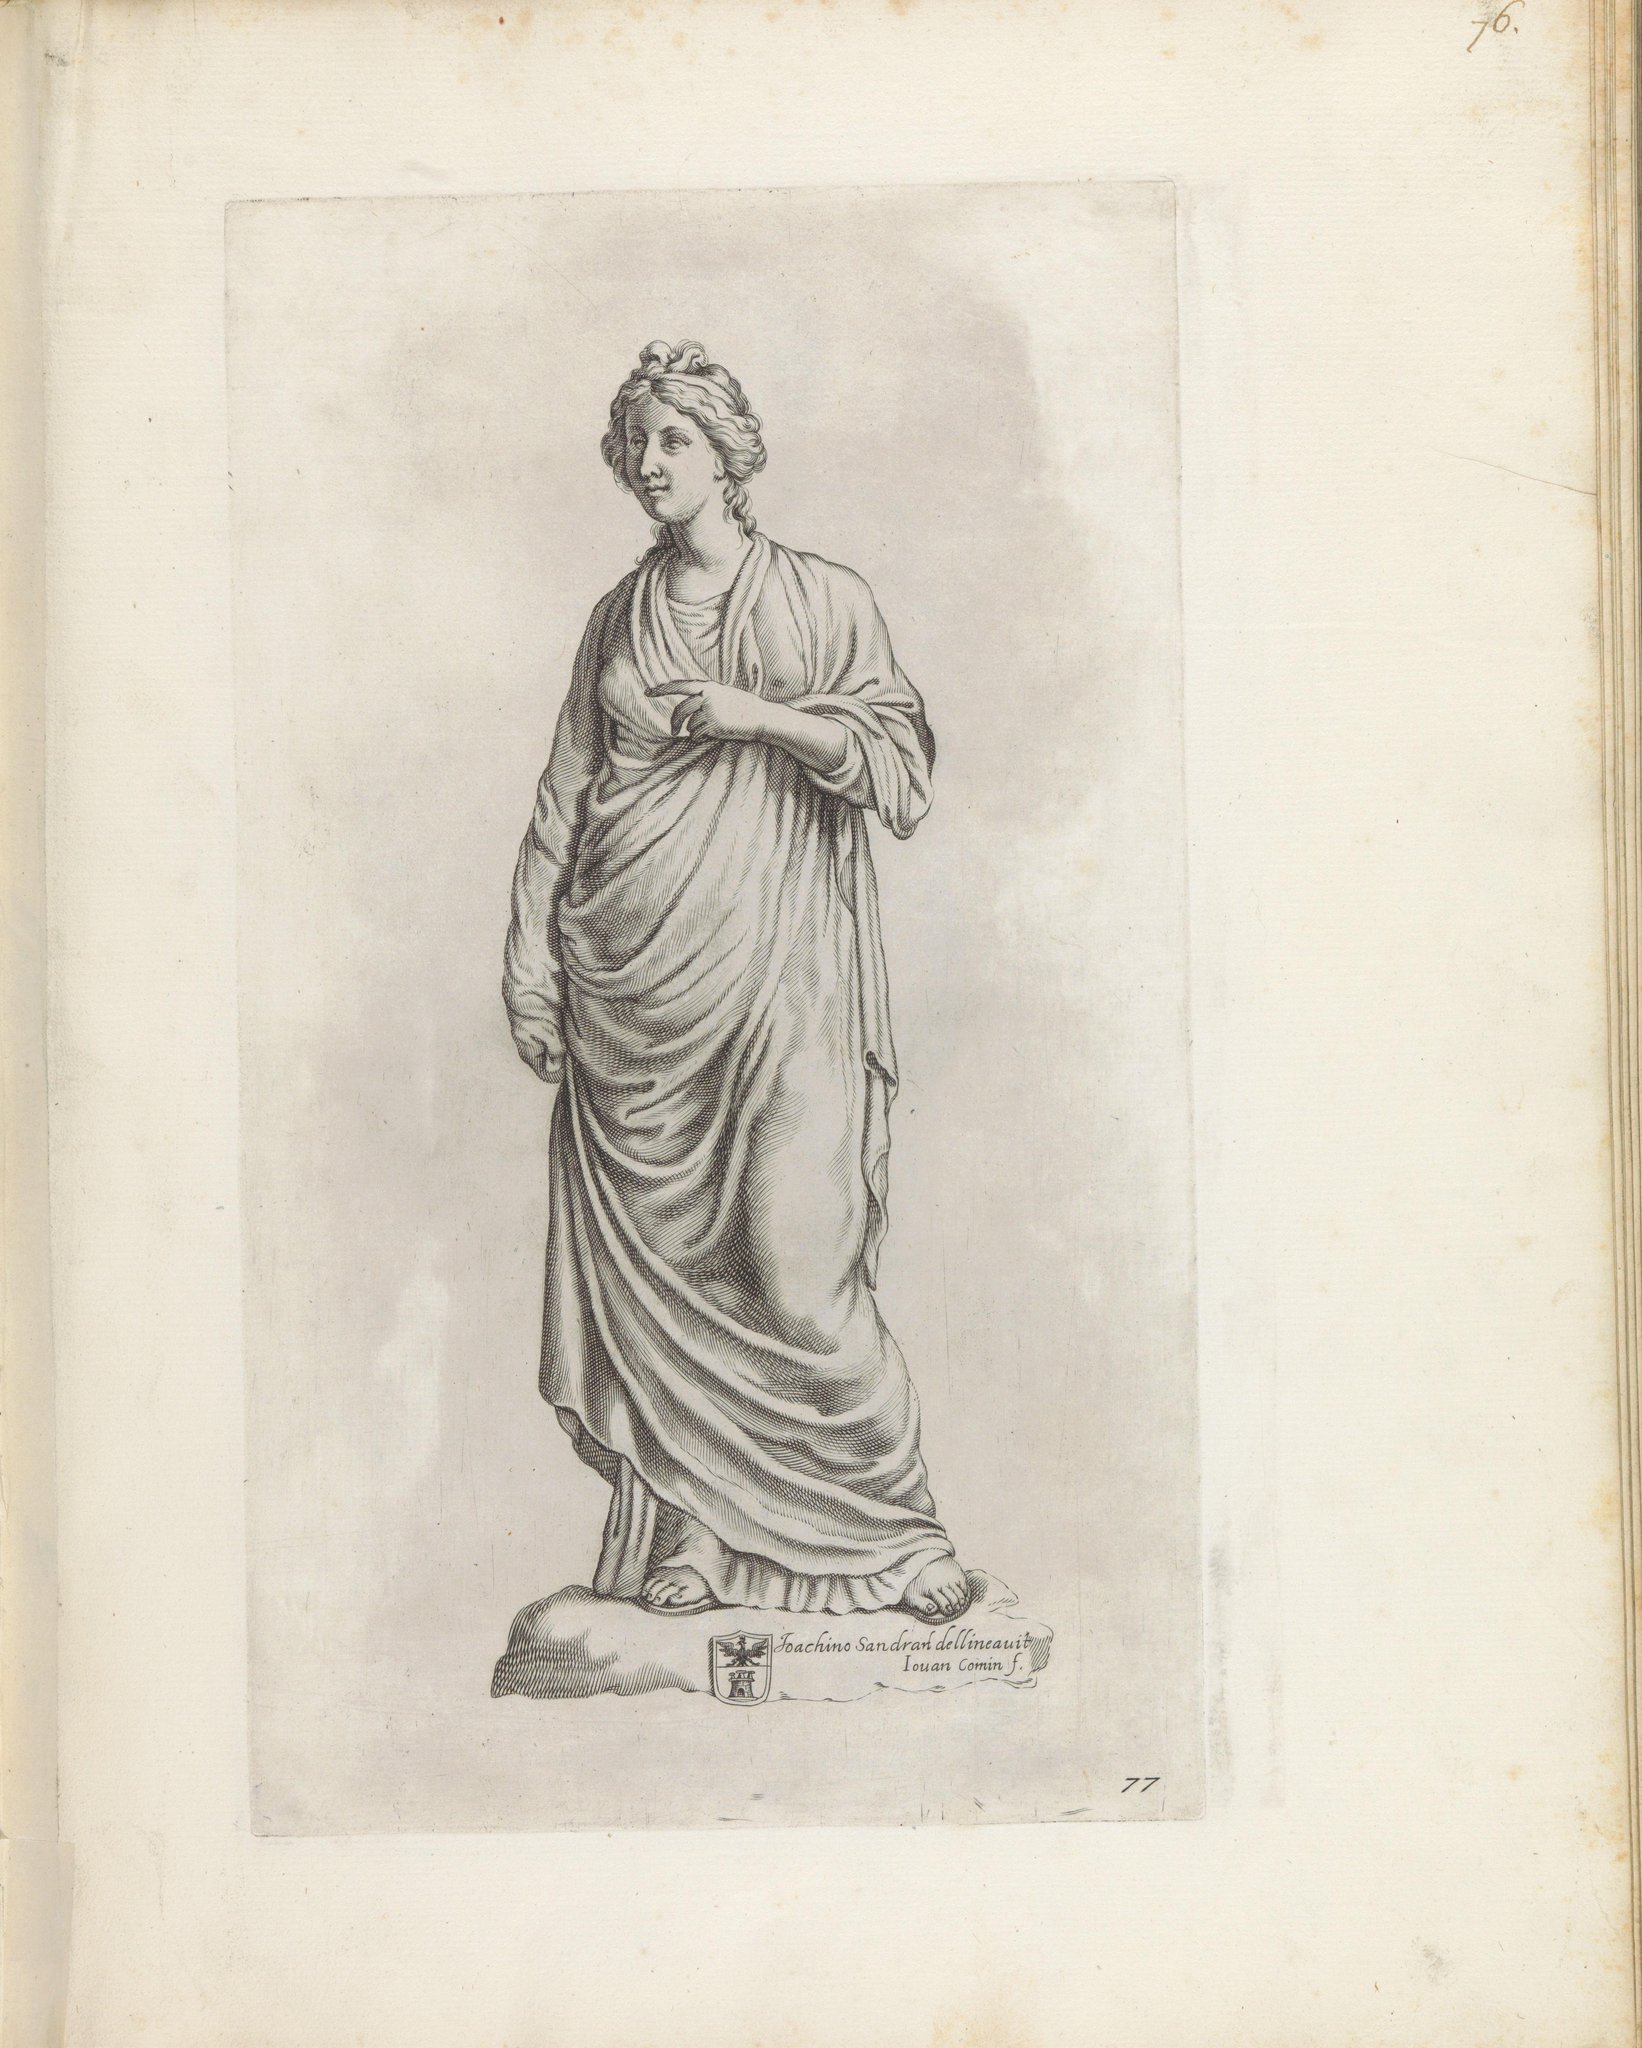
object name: print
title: Galleria Giustiniana del Marchese Vincenzo Giustiniani I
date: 1636-1647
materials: paper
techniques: engraving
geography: rome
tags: piece of sculpture, reproduction of a piece of sculpture, female persons from classical history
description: Standbeeld van een staande vrouw wijzend met de linkerhand. Op de basis het wapenschild van Vincenzo Giustiniani. Prent maakt deel uit van een album met een serie prenten naar de sculpturen in de verzameling in de Galleria Giustiniani te Rome.